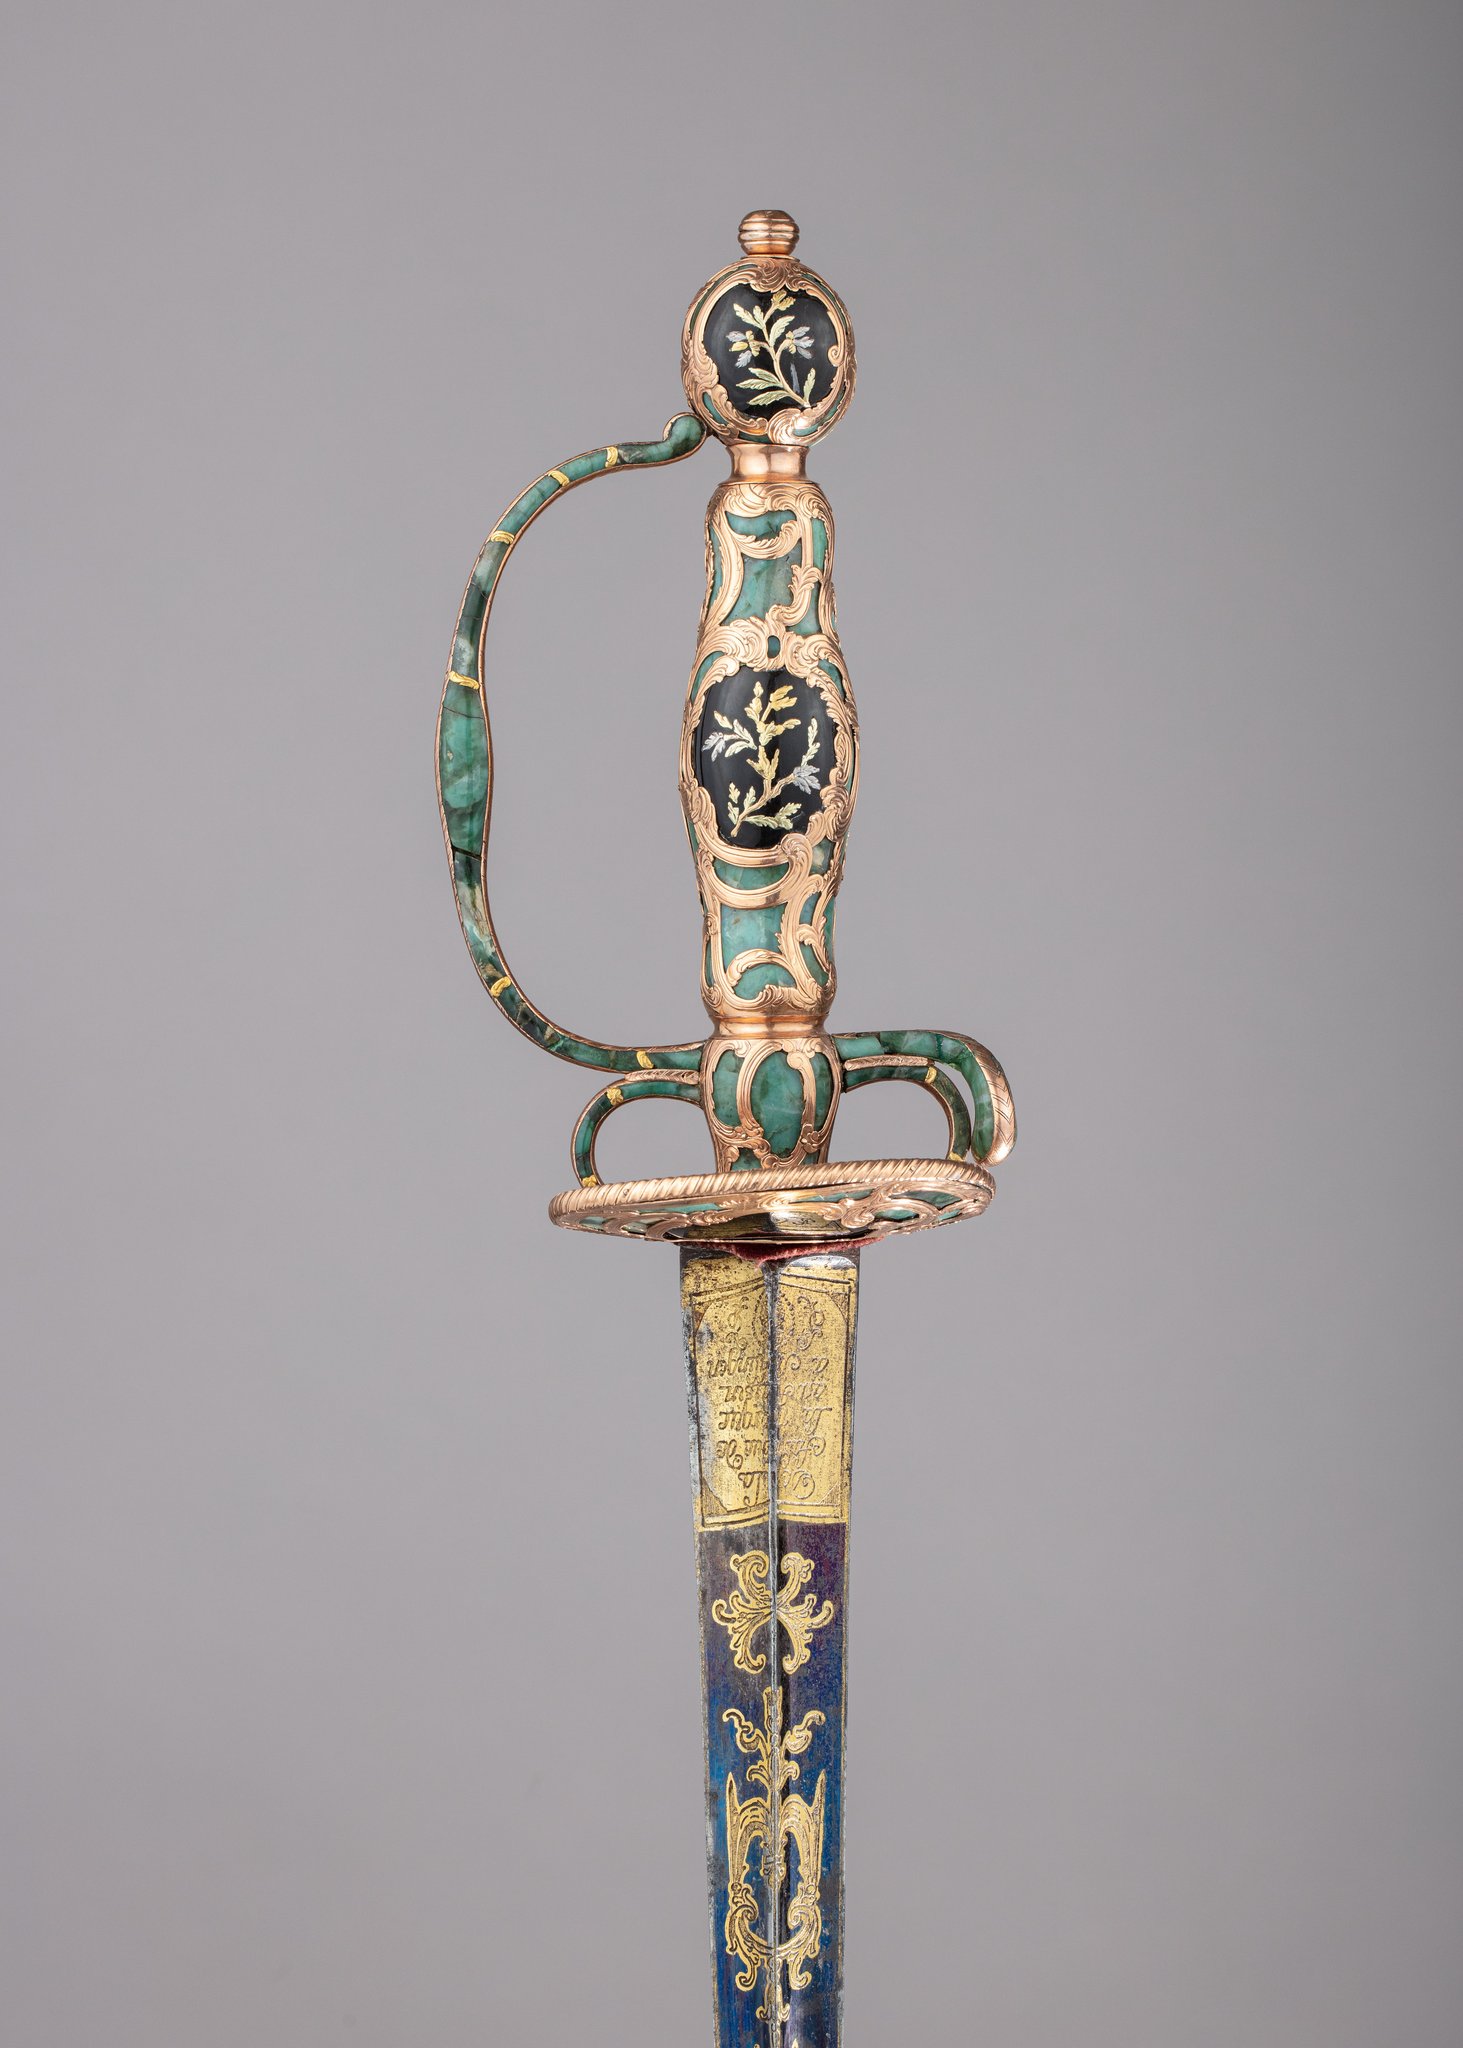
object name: smallsword with scabbard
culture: german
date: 1750-1760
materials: gold, steel, stone, textile, parchment, wood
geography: germany